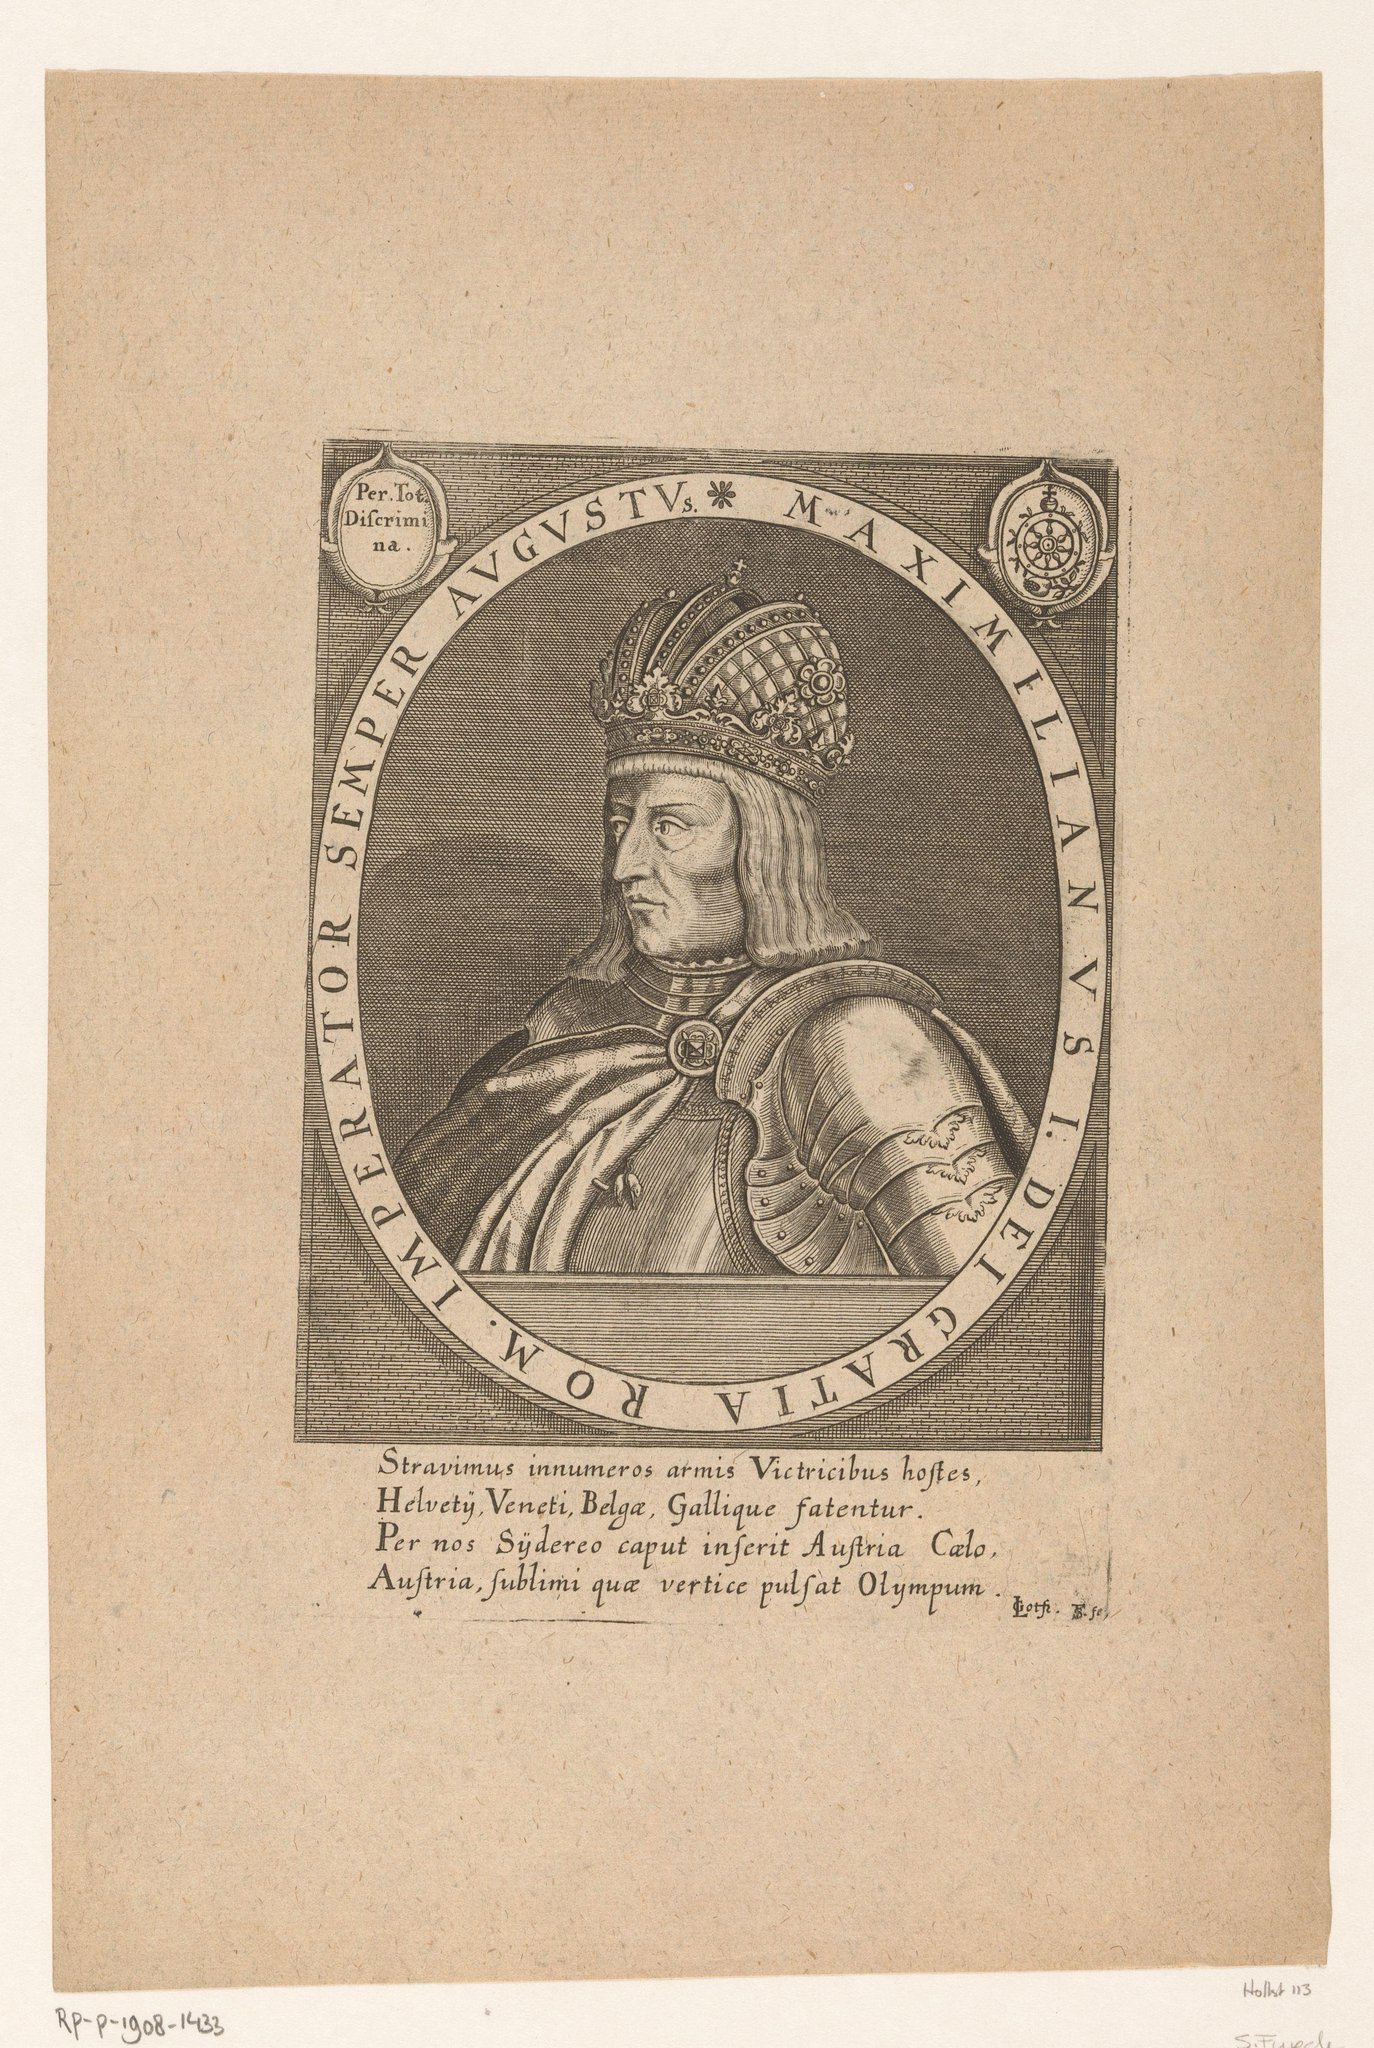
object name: print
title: Portret van keizer Maximiliaan I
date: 1641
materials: paper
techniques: engraving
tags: maximilian i (holy roman emperor), historical persons, emperor, abstract ideas and concepts (+ emblematical representation of concept)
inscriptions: collector's mark: Lugt 2228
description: Prent gebruikt voor: Helvicus, Nicolaus. Theatrum Historiae universalis Catholico Protestantium (...). Frankfurt am Main: Johann Gottfried Schönwetter, 1641.